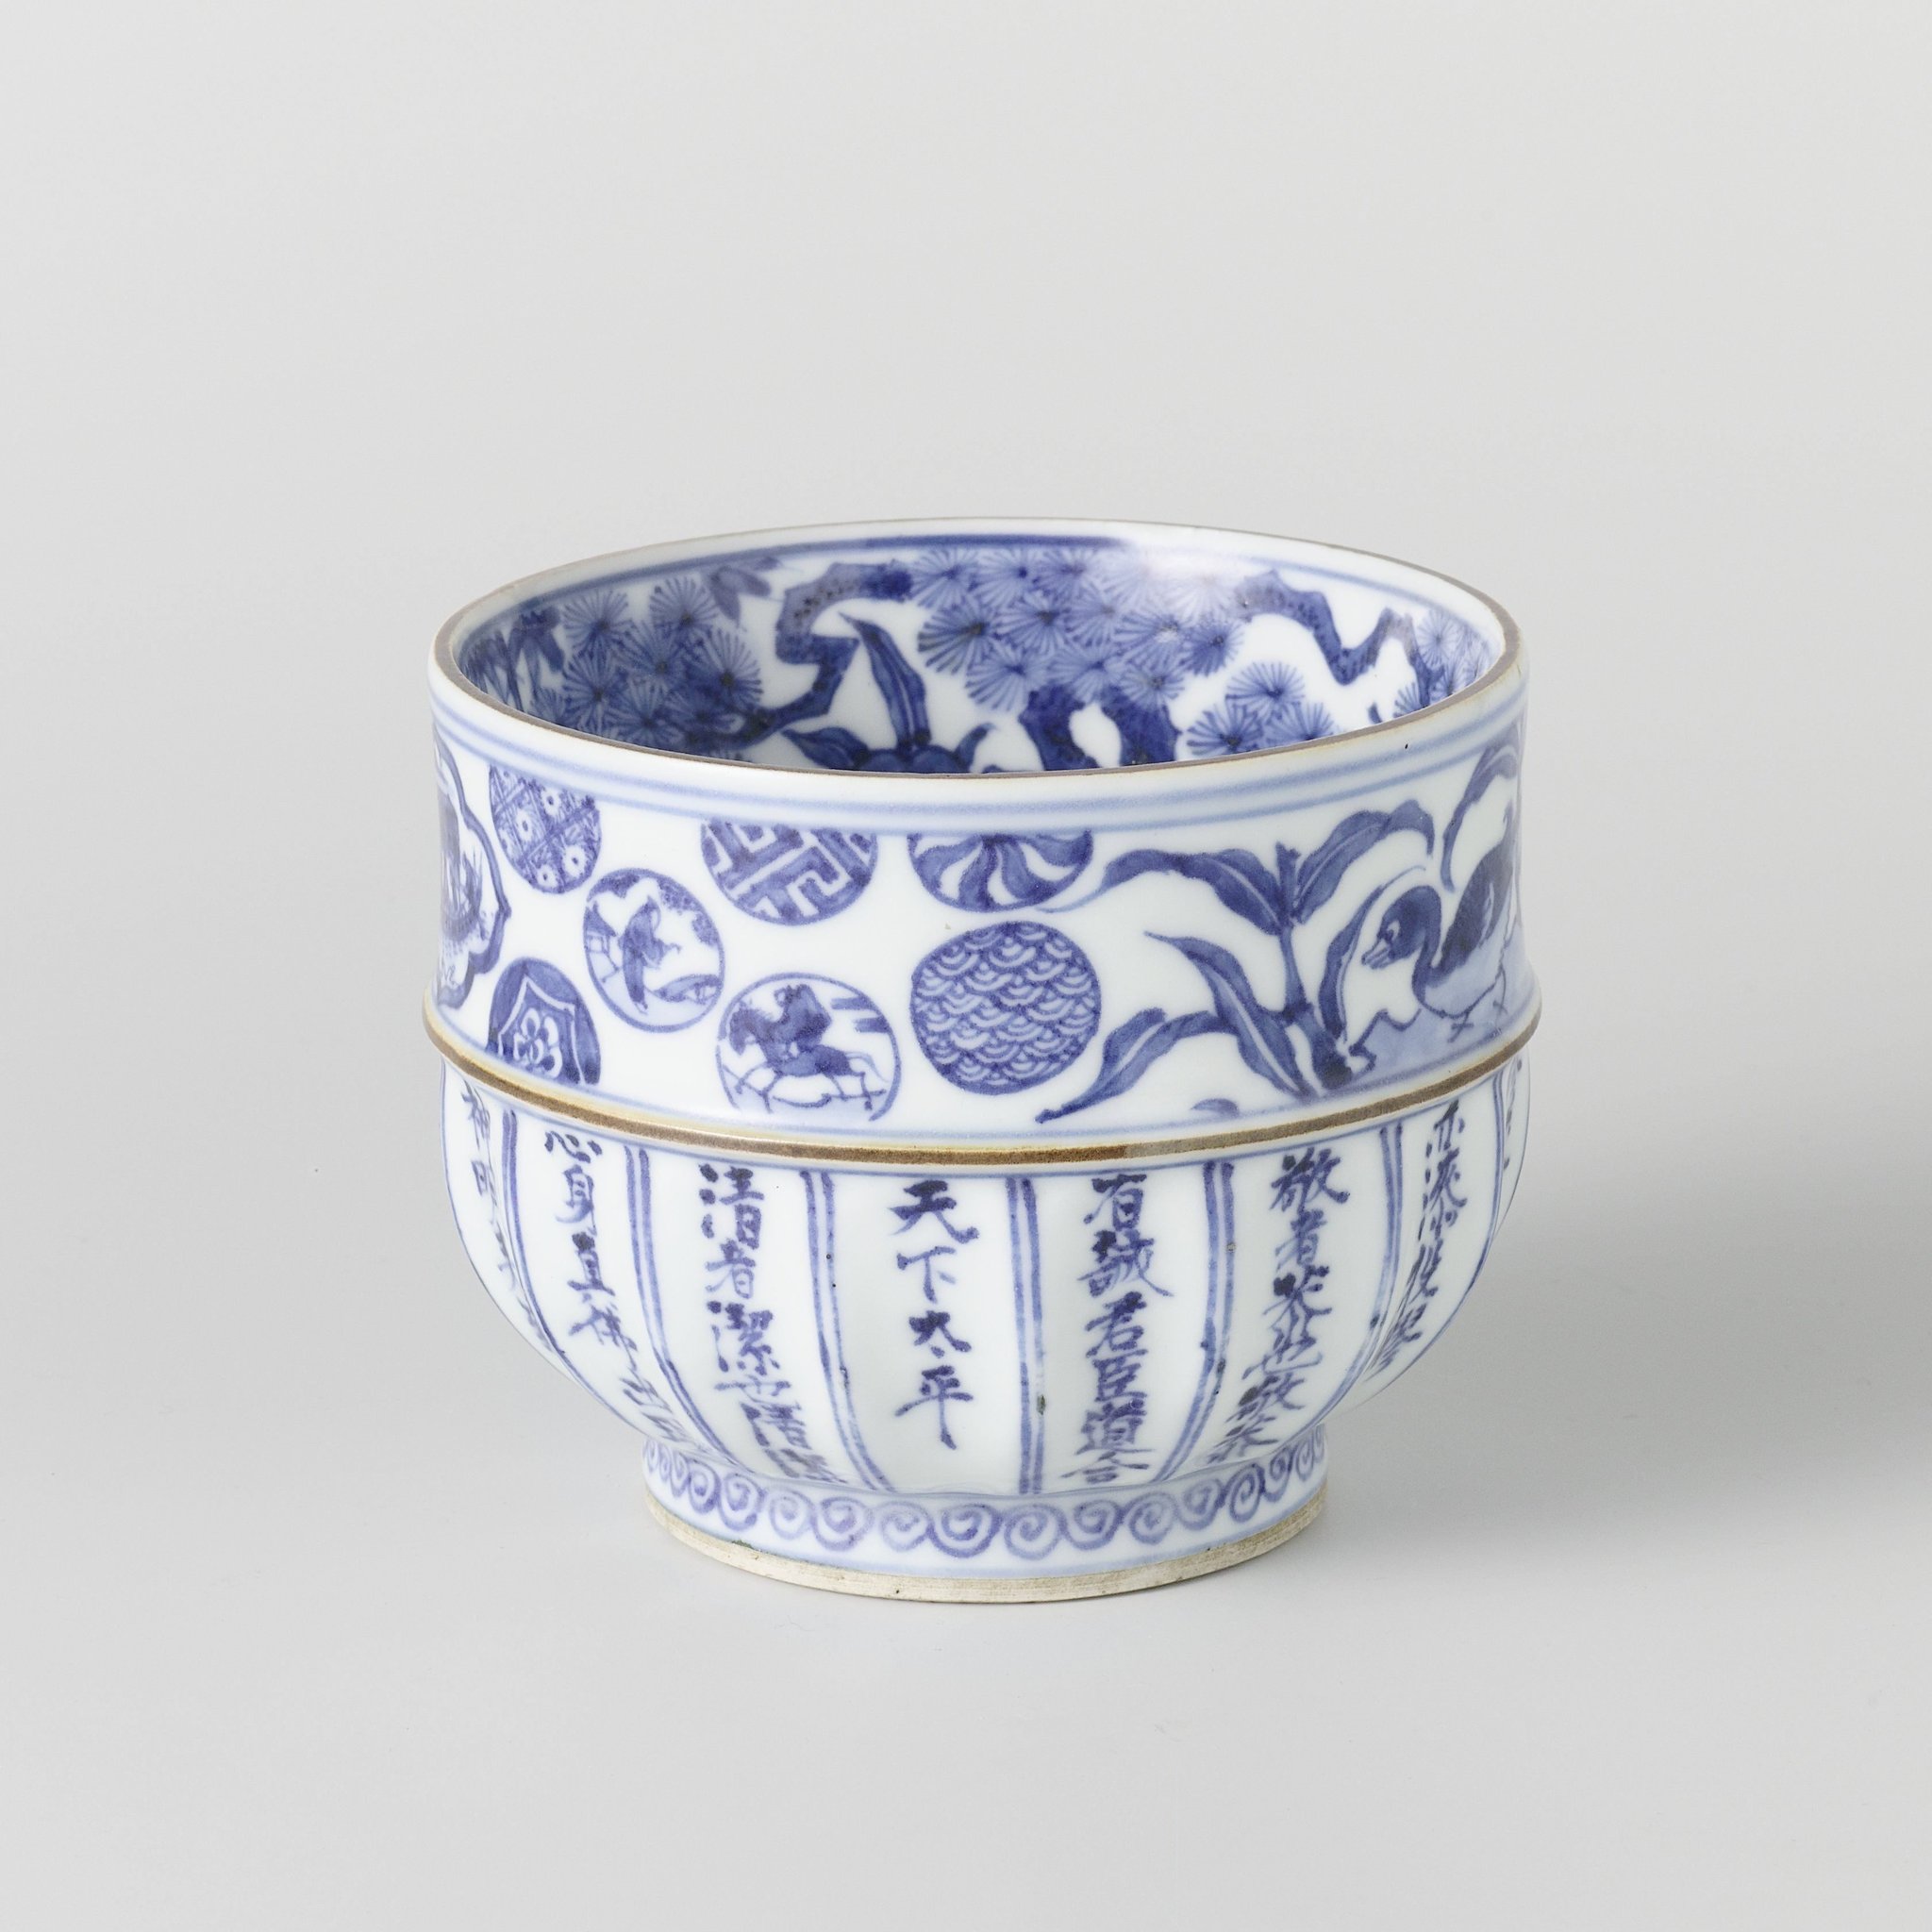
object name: hiire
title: Charcoal burner with flowering plants, birds and an inscription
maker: Anonymous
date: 1800-1849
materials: cobalt, glaze, paint, stoneware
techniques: firing, forming, turning, vitrification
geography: japan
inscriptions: mark, inscription, mark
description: Houtskoolbrander (hiire) van steengoed, beschilderd in onderglazuur blauw. De onderste helft van de kom heeft een geribde wand, verdeeld in een band langwerpige vakken met karakters. Daarboven een band met drie vogels op een rots of een tak en medaillons en cartouches met landschappen, personen of servetwerk. De binnenrand met een brede band met de 'drie vrienden van de winter' (bamboe, pijnboom, prunus), met een vogel op de prunustak. De bodem is ongeglazuurd. Gemerkt op de onderzijde met een zes-karaktermerk in een dubbele cirkel en een ingedrukt vier-karaktermerk. Kyoyaki.